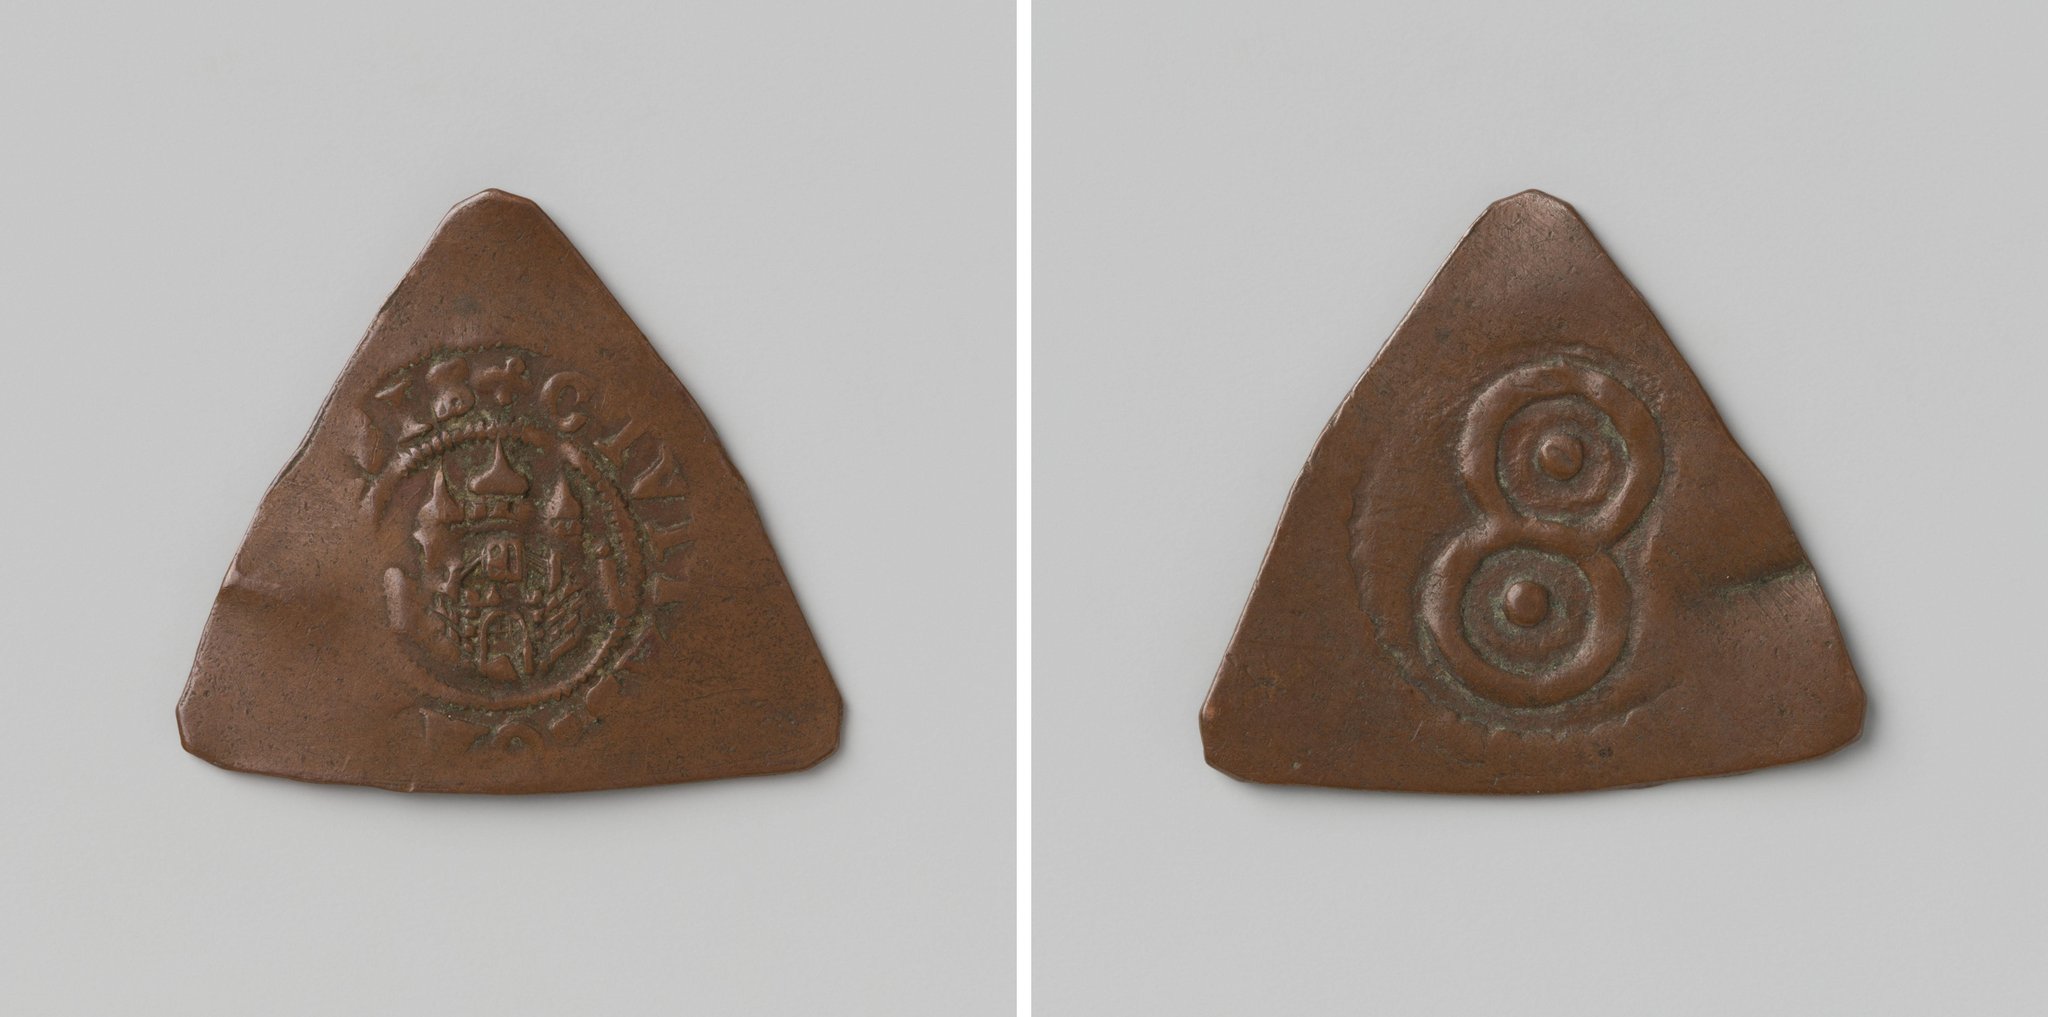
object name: armenloodje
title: Stad Kampen, loodje met cijfer 8 dat bij uitdeling recht gaf op brood of graan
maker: Anonymous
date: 1600-1800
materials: copper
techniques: striking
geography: kampen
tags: kampen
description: Koperen driehoekig loodje met afgeschuinde hoeken. Voorzijde: in ronde stempel: burcht binnen omschrift. Keerzijde: cijfer 8.